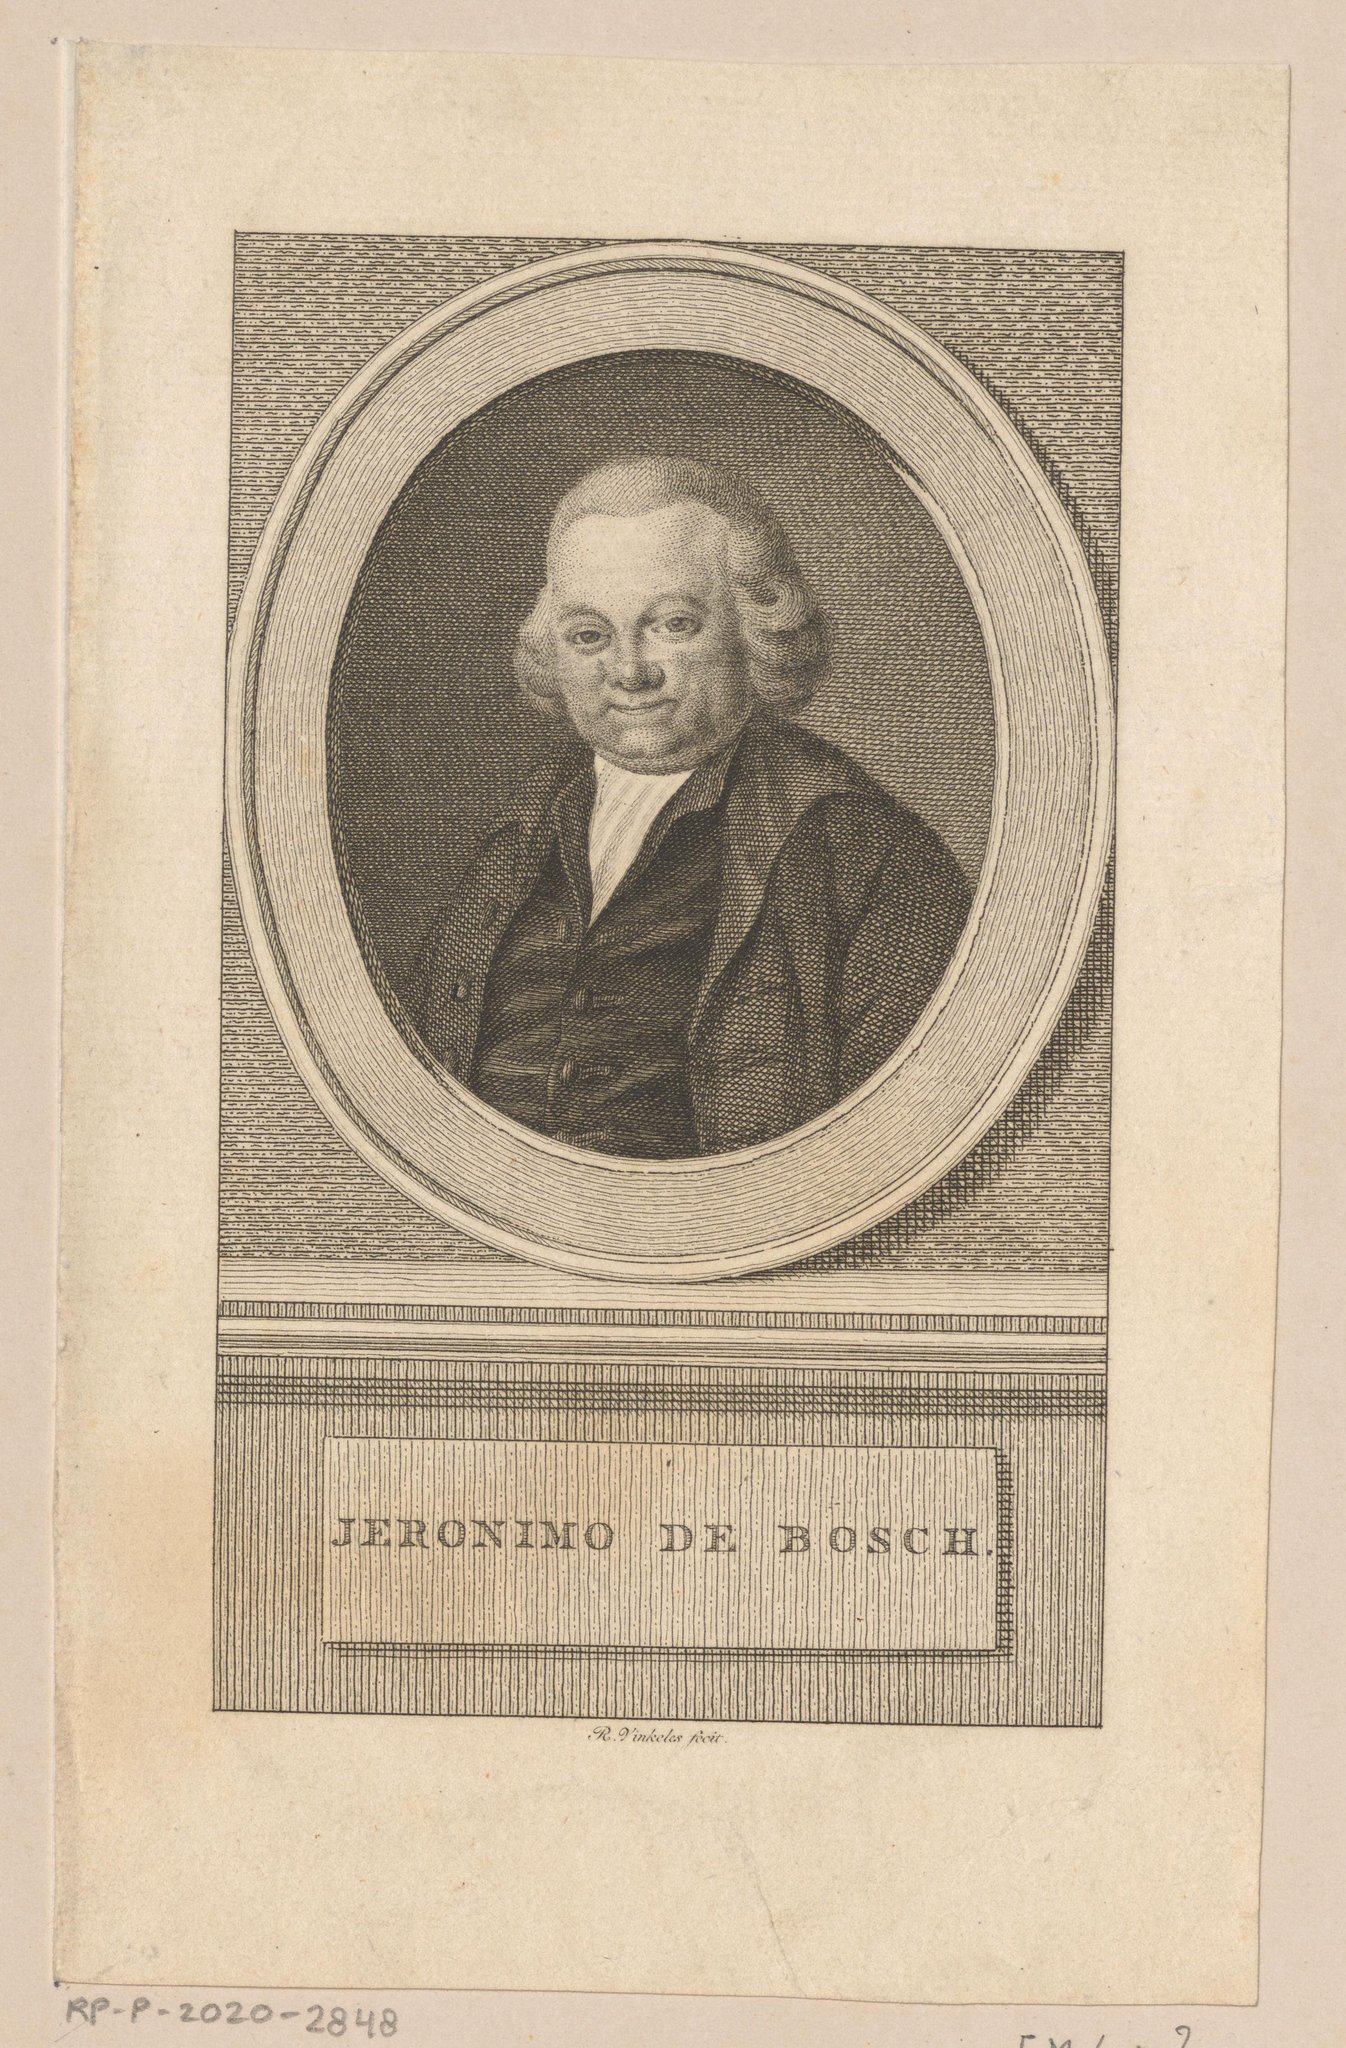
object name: book illustration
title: Portret van Jeronimo de Bosch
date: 1786-1811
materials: paper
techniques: engraving, etching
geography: amsterdam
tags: amsterdam, jeronimo de bosch, historical persons, writer, poet, author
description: Prent uit: Loosjes, Petrus. Vaderlandsche historie, (...) ten vervolge van Wagenaars Vaderlandsche historie. Amsterdam: Johannes Allart, 1786-1811, dl. 44.